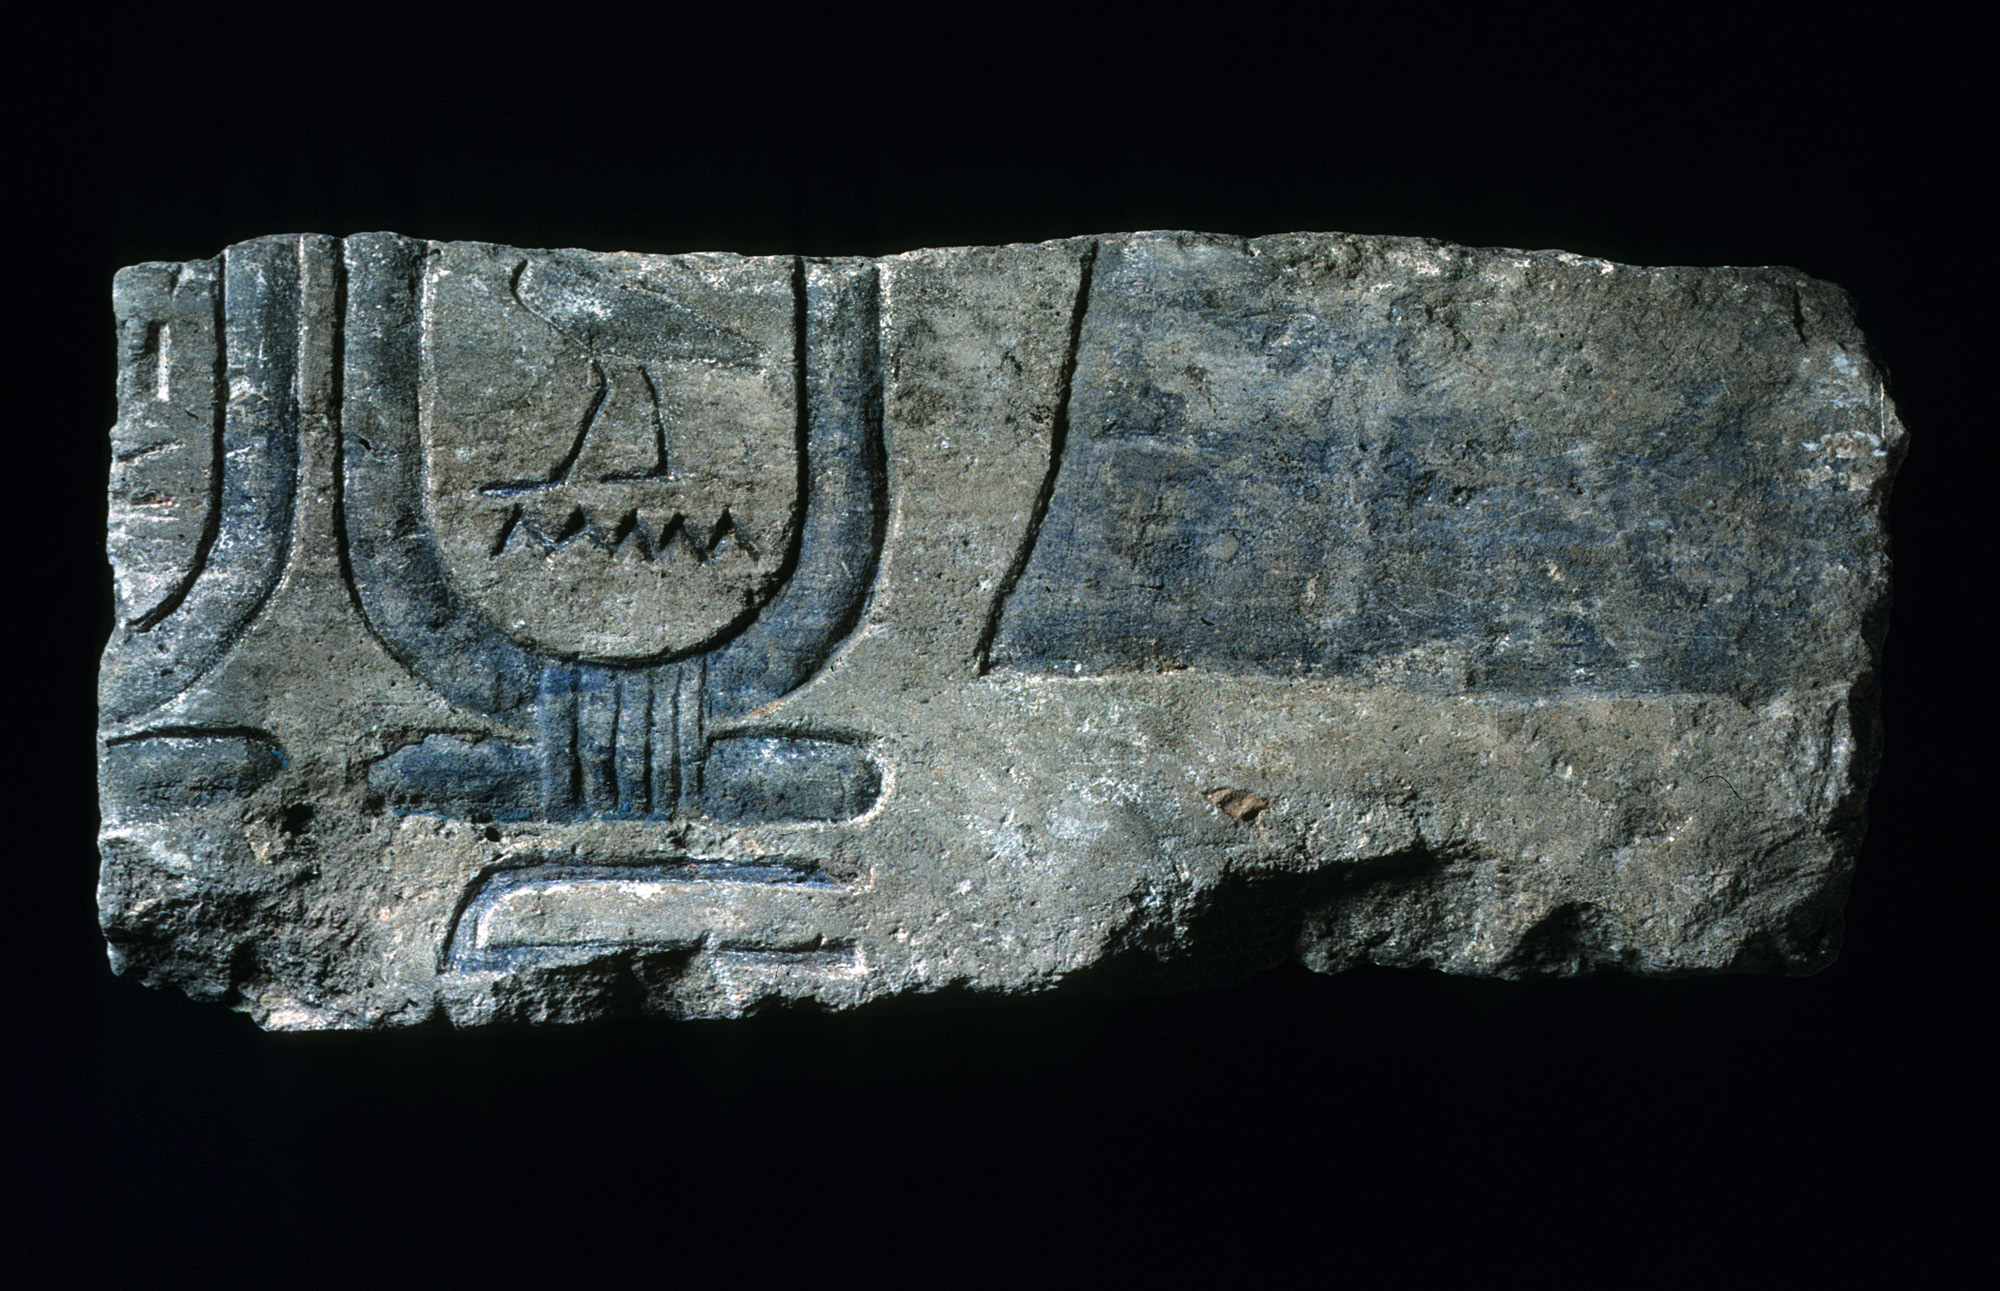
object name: talatat, royal titulature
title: Relief with royal titulature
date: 1353-1336 BCE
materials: limestone, paint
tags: cartouches